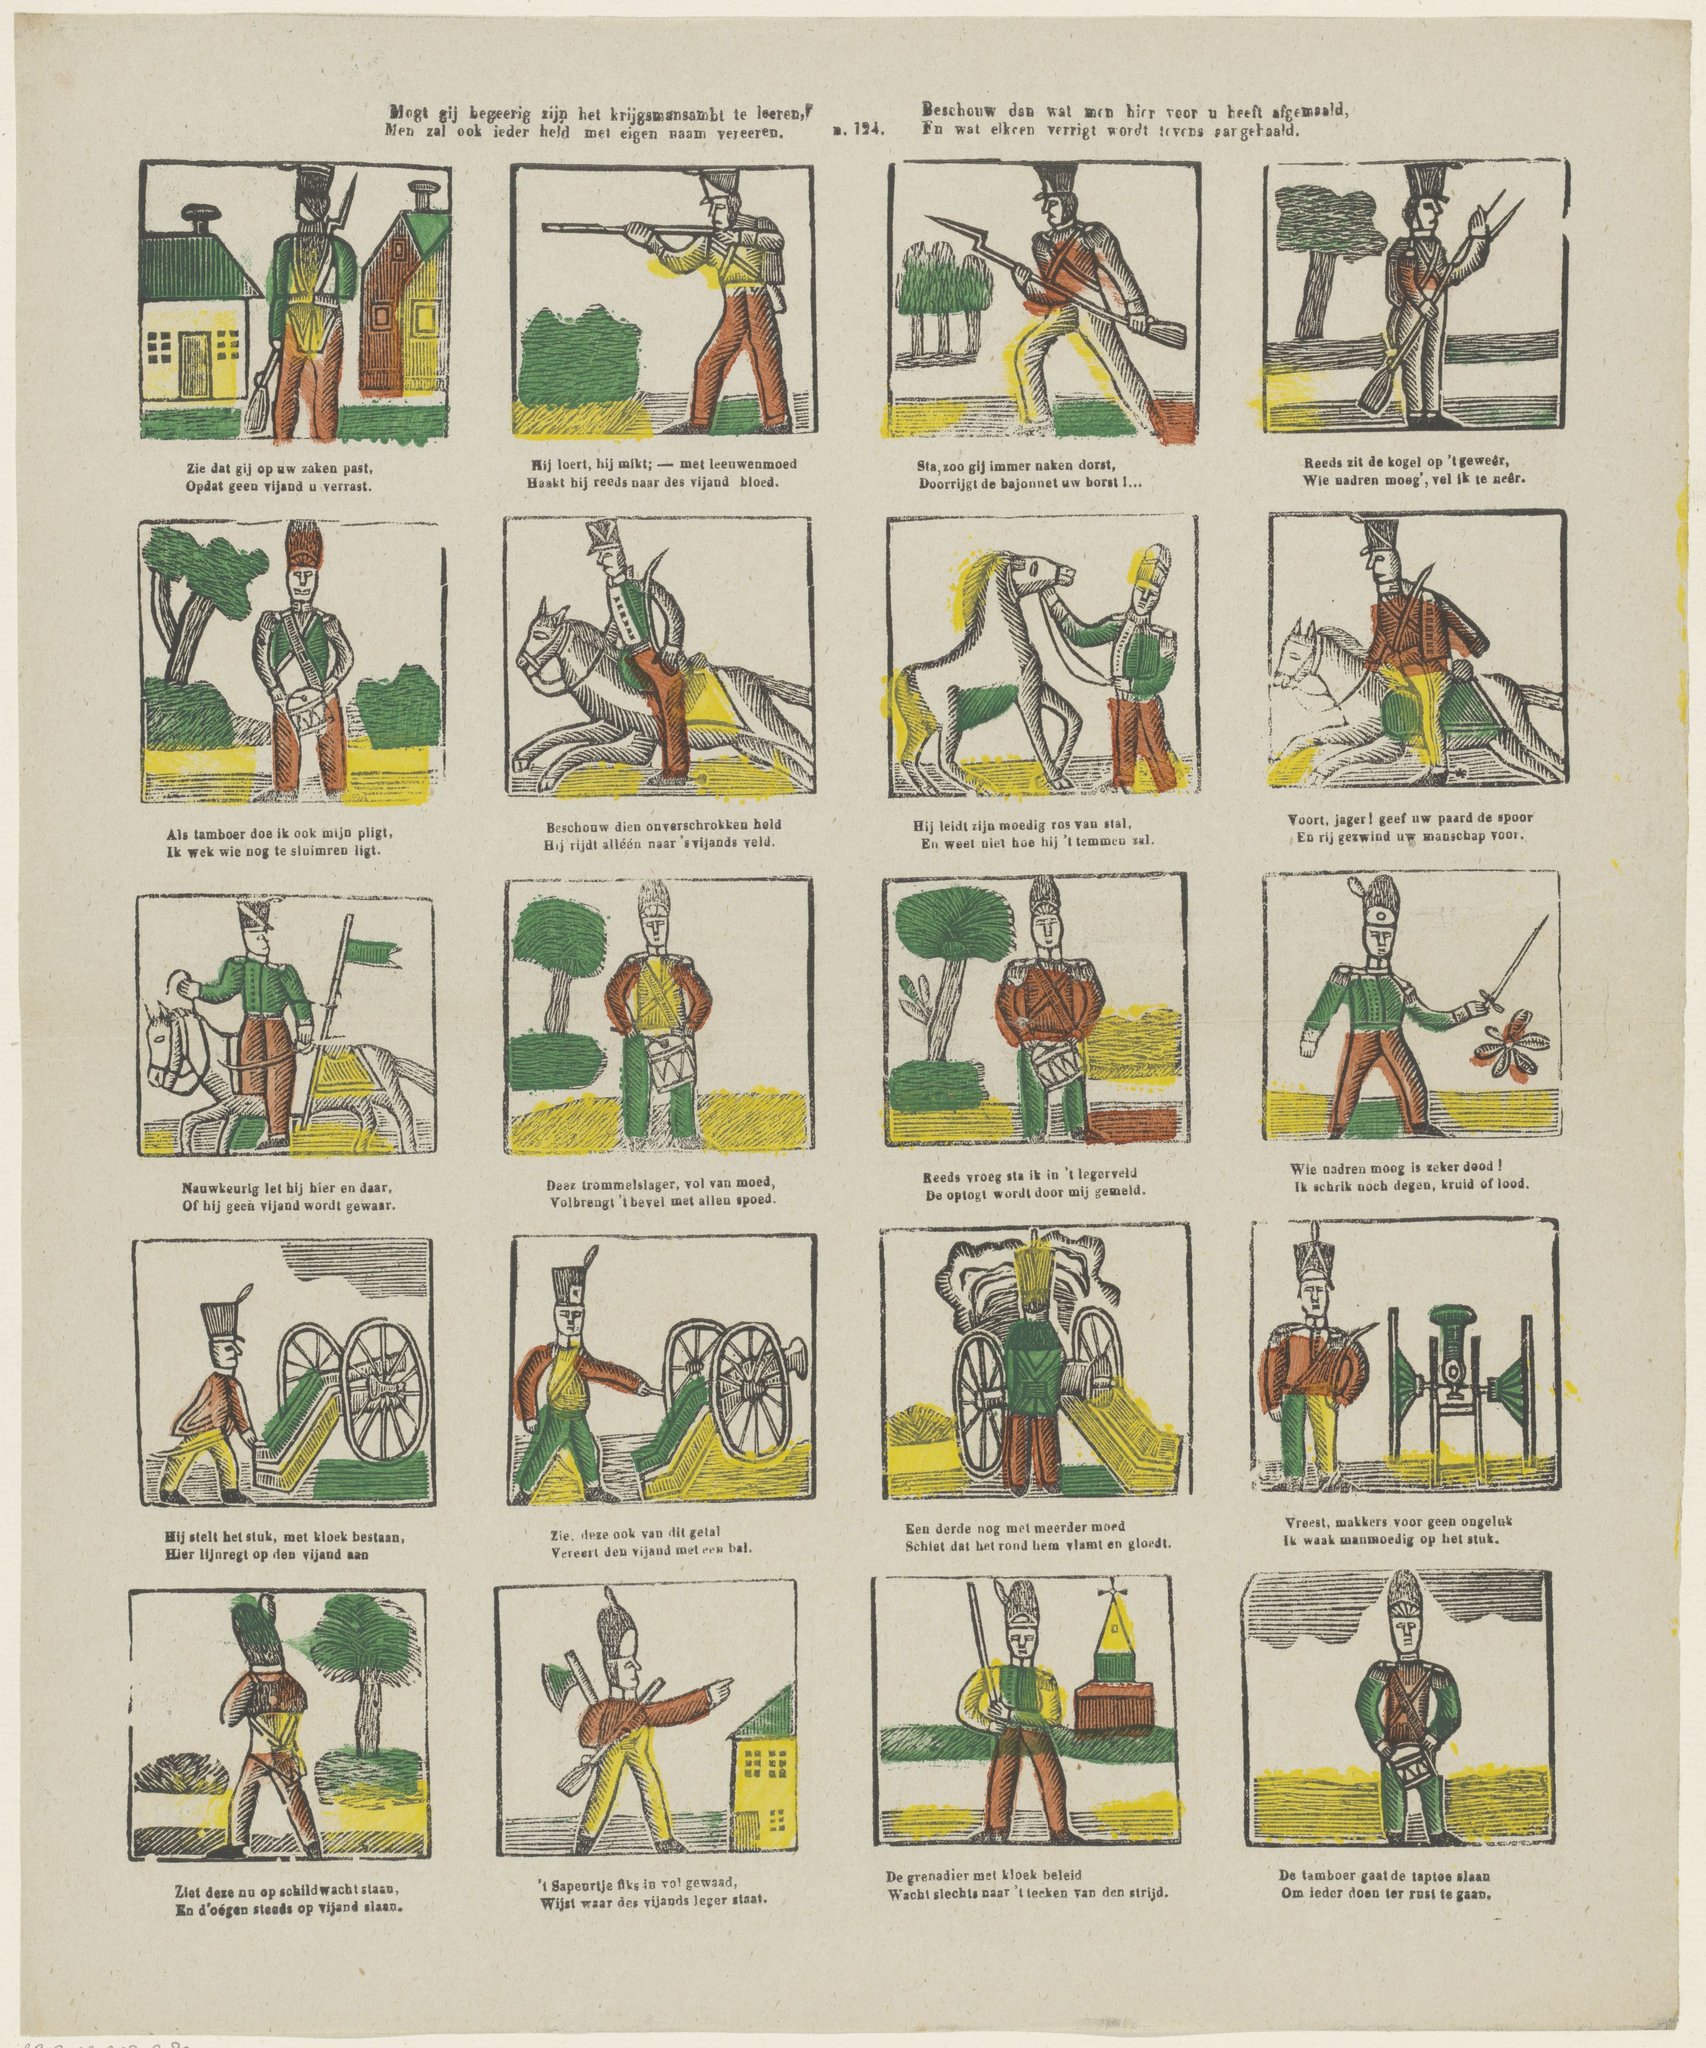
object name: print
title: Mogt gij begeerig zijn het krijgsmansambt te leeren, / Men zal ook ieder held met eigen naam vereeren. / Beschouw dan wat men hier voor u heeft afgenaald, / En wat elkeen verrigt wordt tevens aangehaald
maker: Anonymous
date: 1856-1900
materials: paper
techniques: colour, letterpress printing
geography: turnhout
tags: firearms: cannon (+ handling of weapons), warfare; military affairs (+ cavalry, horsemen), the soldier; the soldier's life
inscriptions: collector's mark: Lugt 2760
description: Blad met 20 voorstellingen van militaire taferelen, zoals een militair te paard en een soldaat die een kanon afvuurt. Onder elke afbeelding een tweeregelig vers. Genummerd midden boven: n. 124.